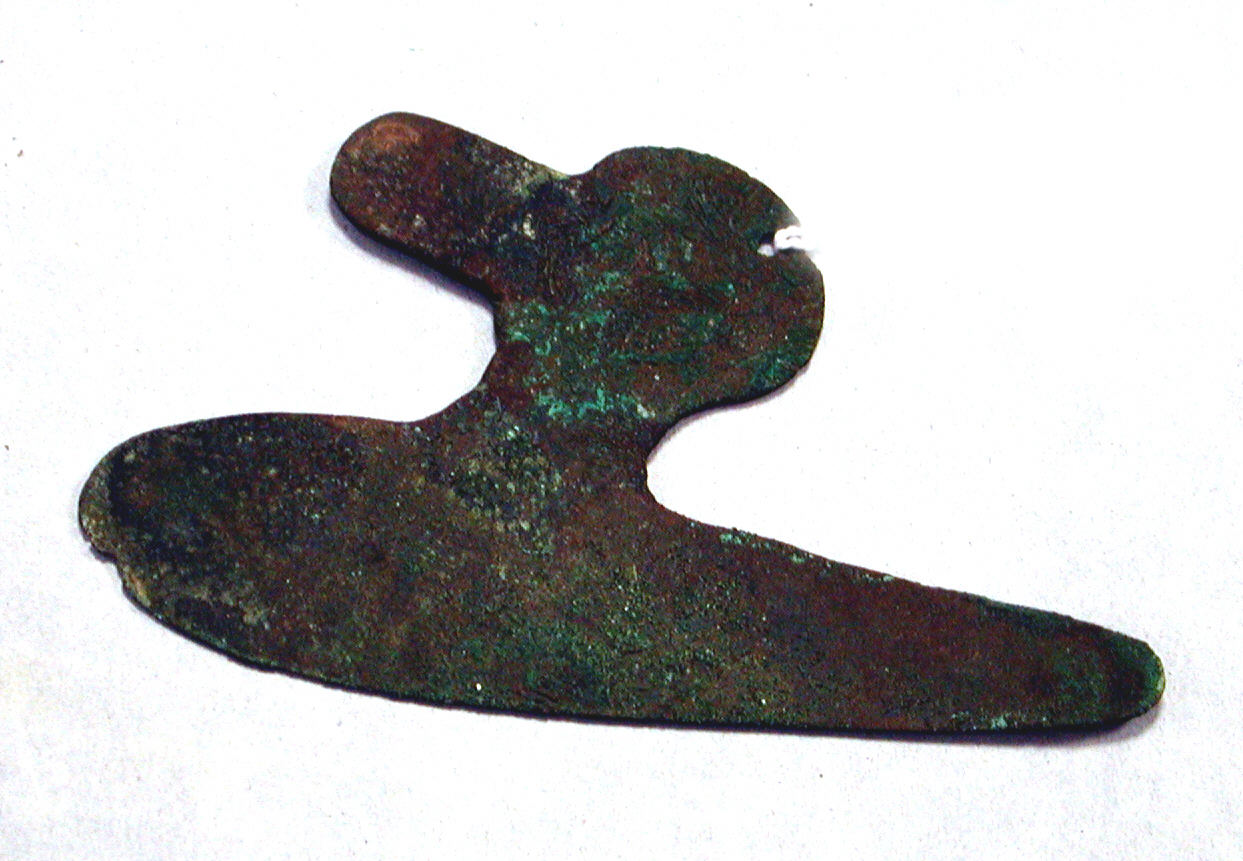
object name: ornament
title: Copper Animal Ornament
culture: chimú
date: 1101-1500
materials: copper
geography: peru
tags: animals